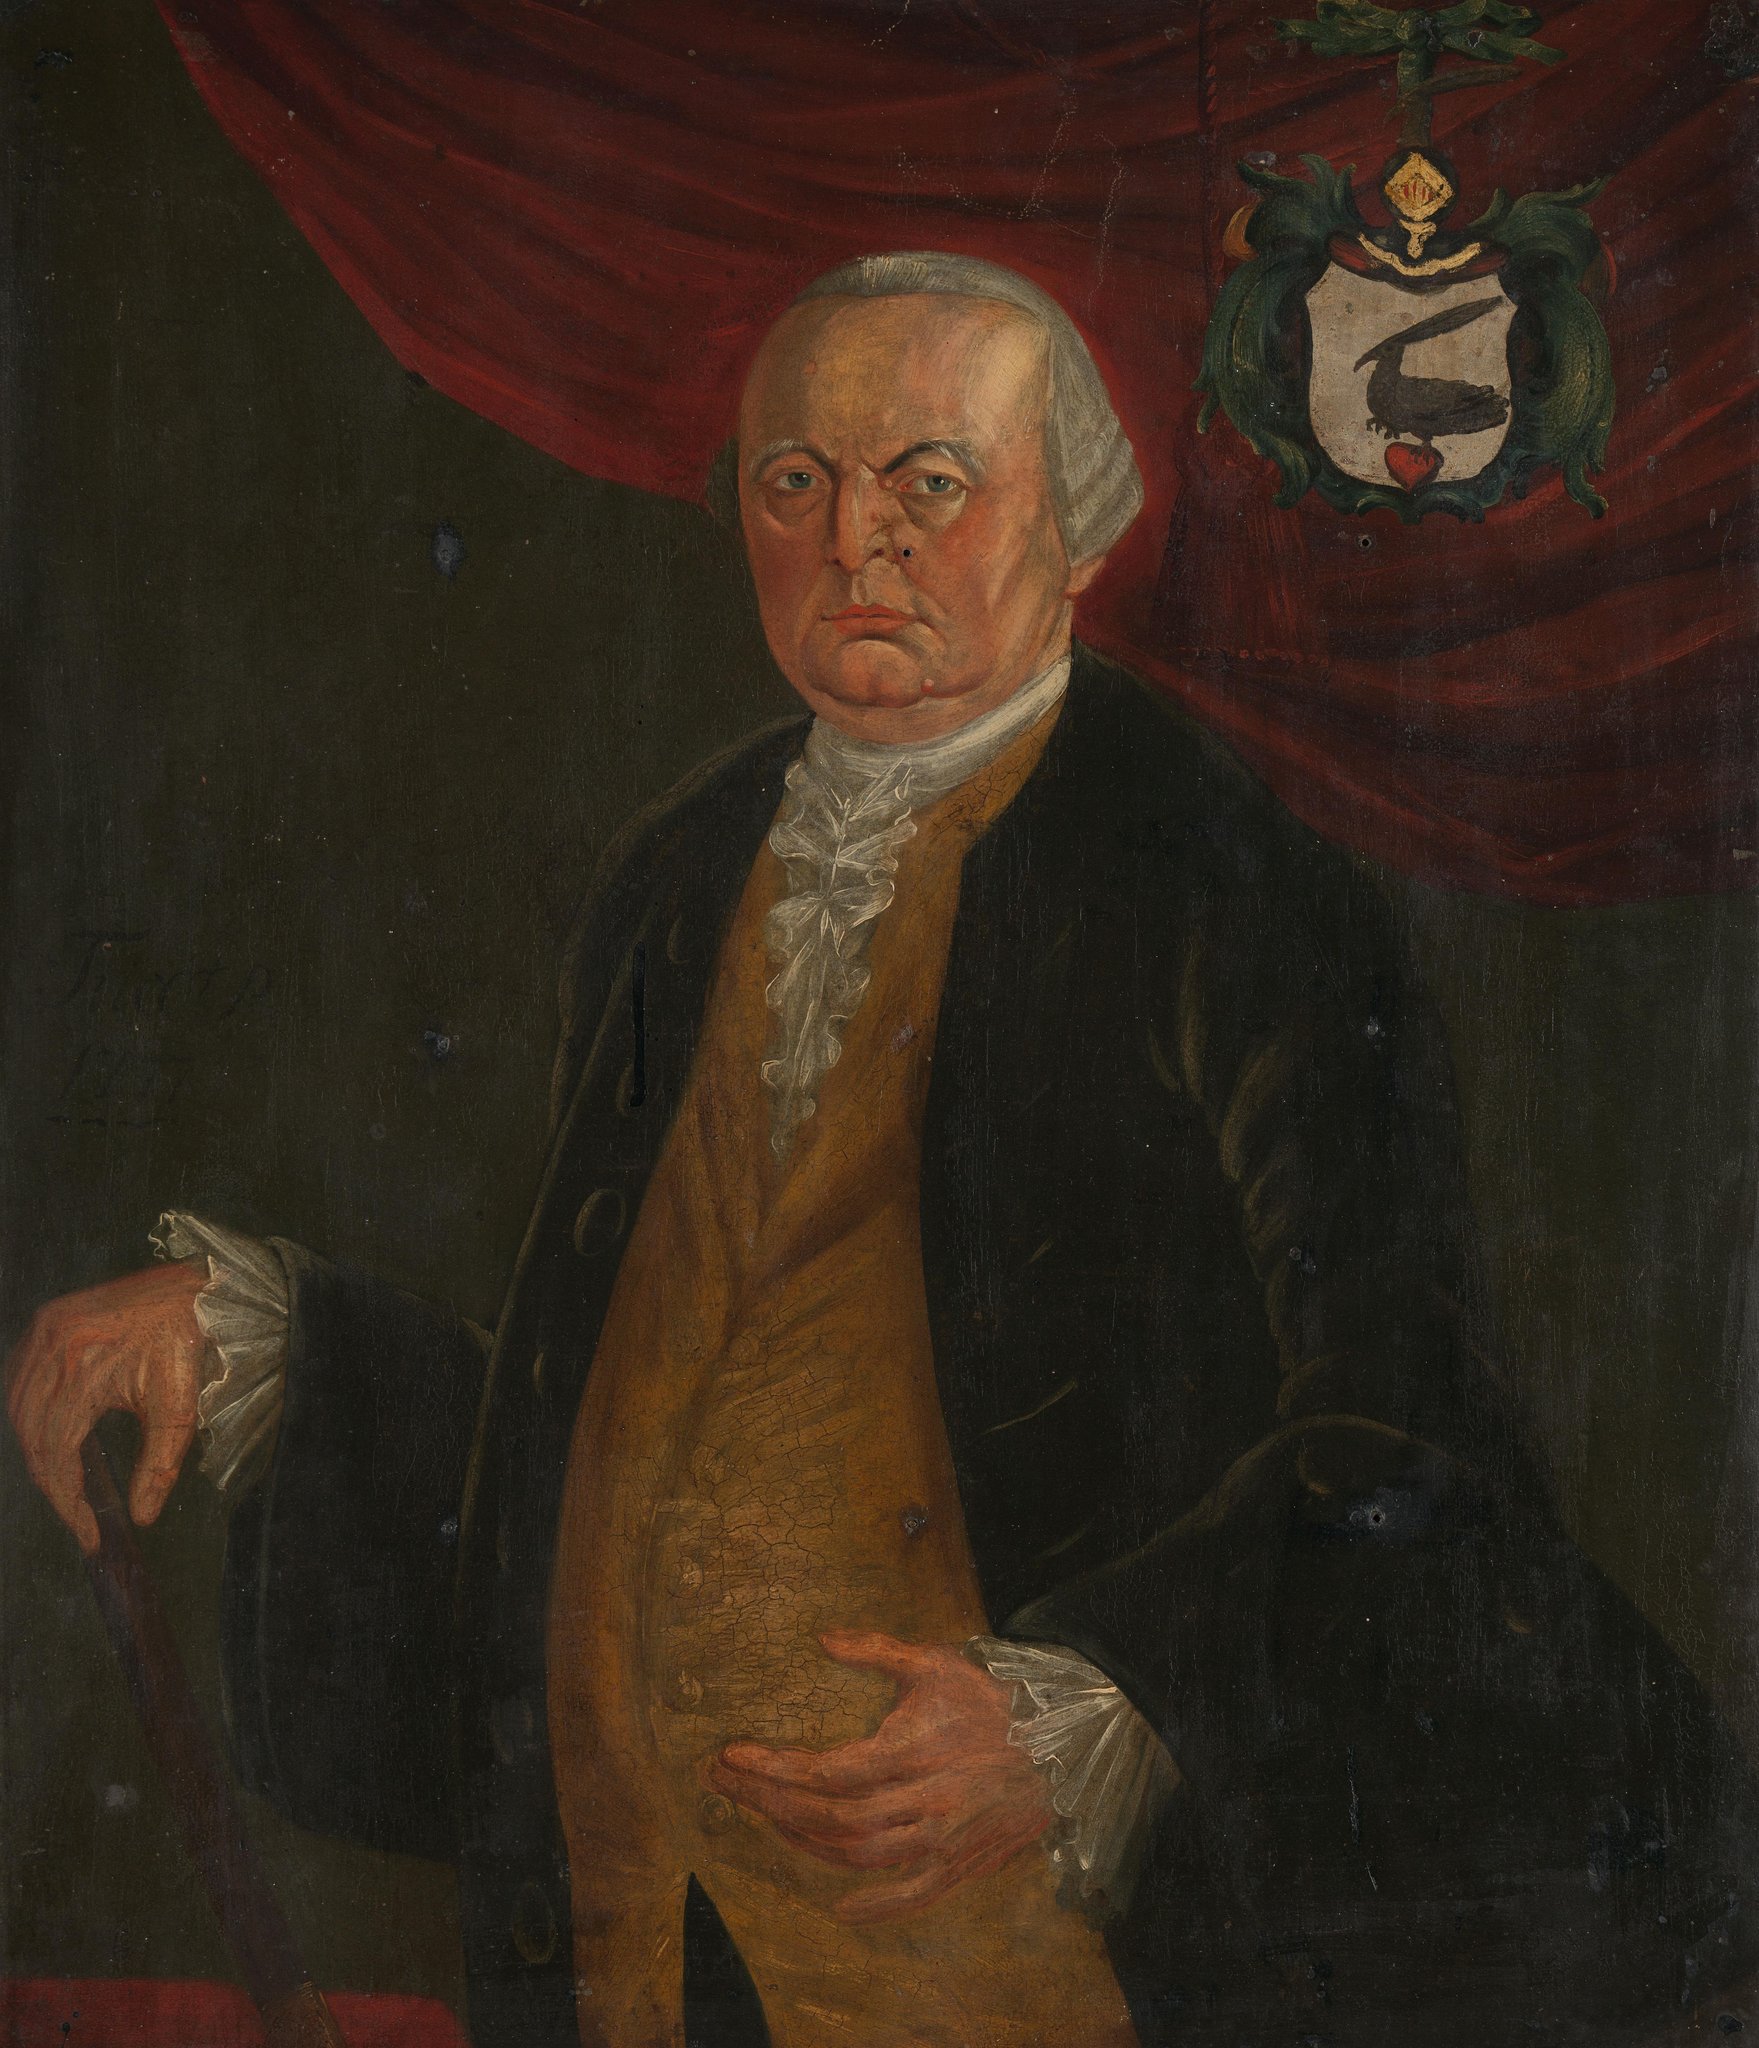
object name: painting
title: Portrait of Reinier de Klerk, Governor-General of the Dutch East India Company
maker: franciscus josephus fricot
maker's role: painter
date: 1777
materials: bronze, oil, panel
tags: middelburg, batavia, colonial governor, historical persons, baton of general, dutch east indies, the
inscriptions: signature and date: ‘Fricot [of Tricot] 1777’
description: Portret van Reinier de Klerk (1710-80). Gouverneur-generaal (1777-80). Ten halven lijve, staande naar links. De rechterhand rustend op een commandostaf op een tafel. Rechtsboven het familiewapen. Onderdeel van een reeks van portretten van de gouverneurs-generaal van het voormalige Nederlands Oost-Indië.